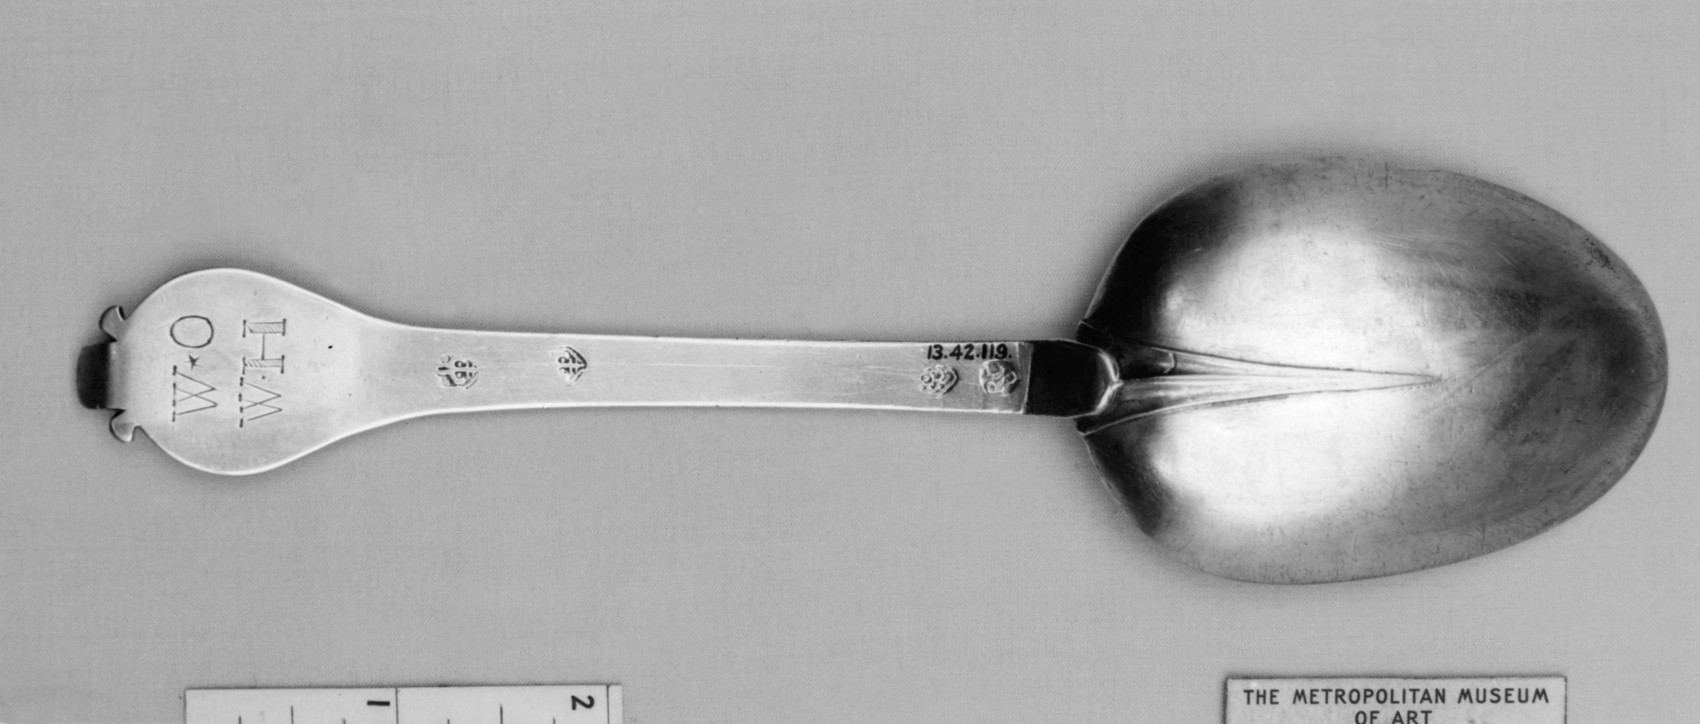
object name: spoon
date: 1690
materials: silver